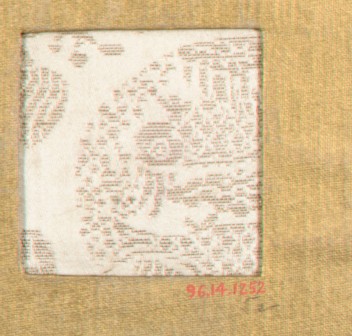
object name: piece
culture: japanese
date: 1701-1900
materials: silk